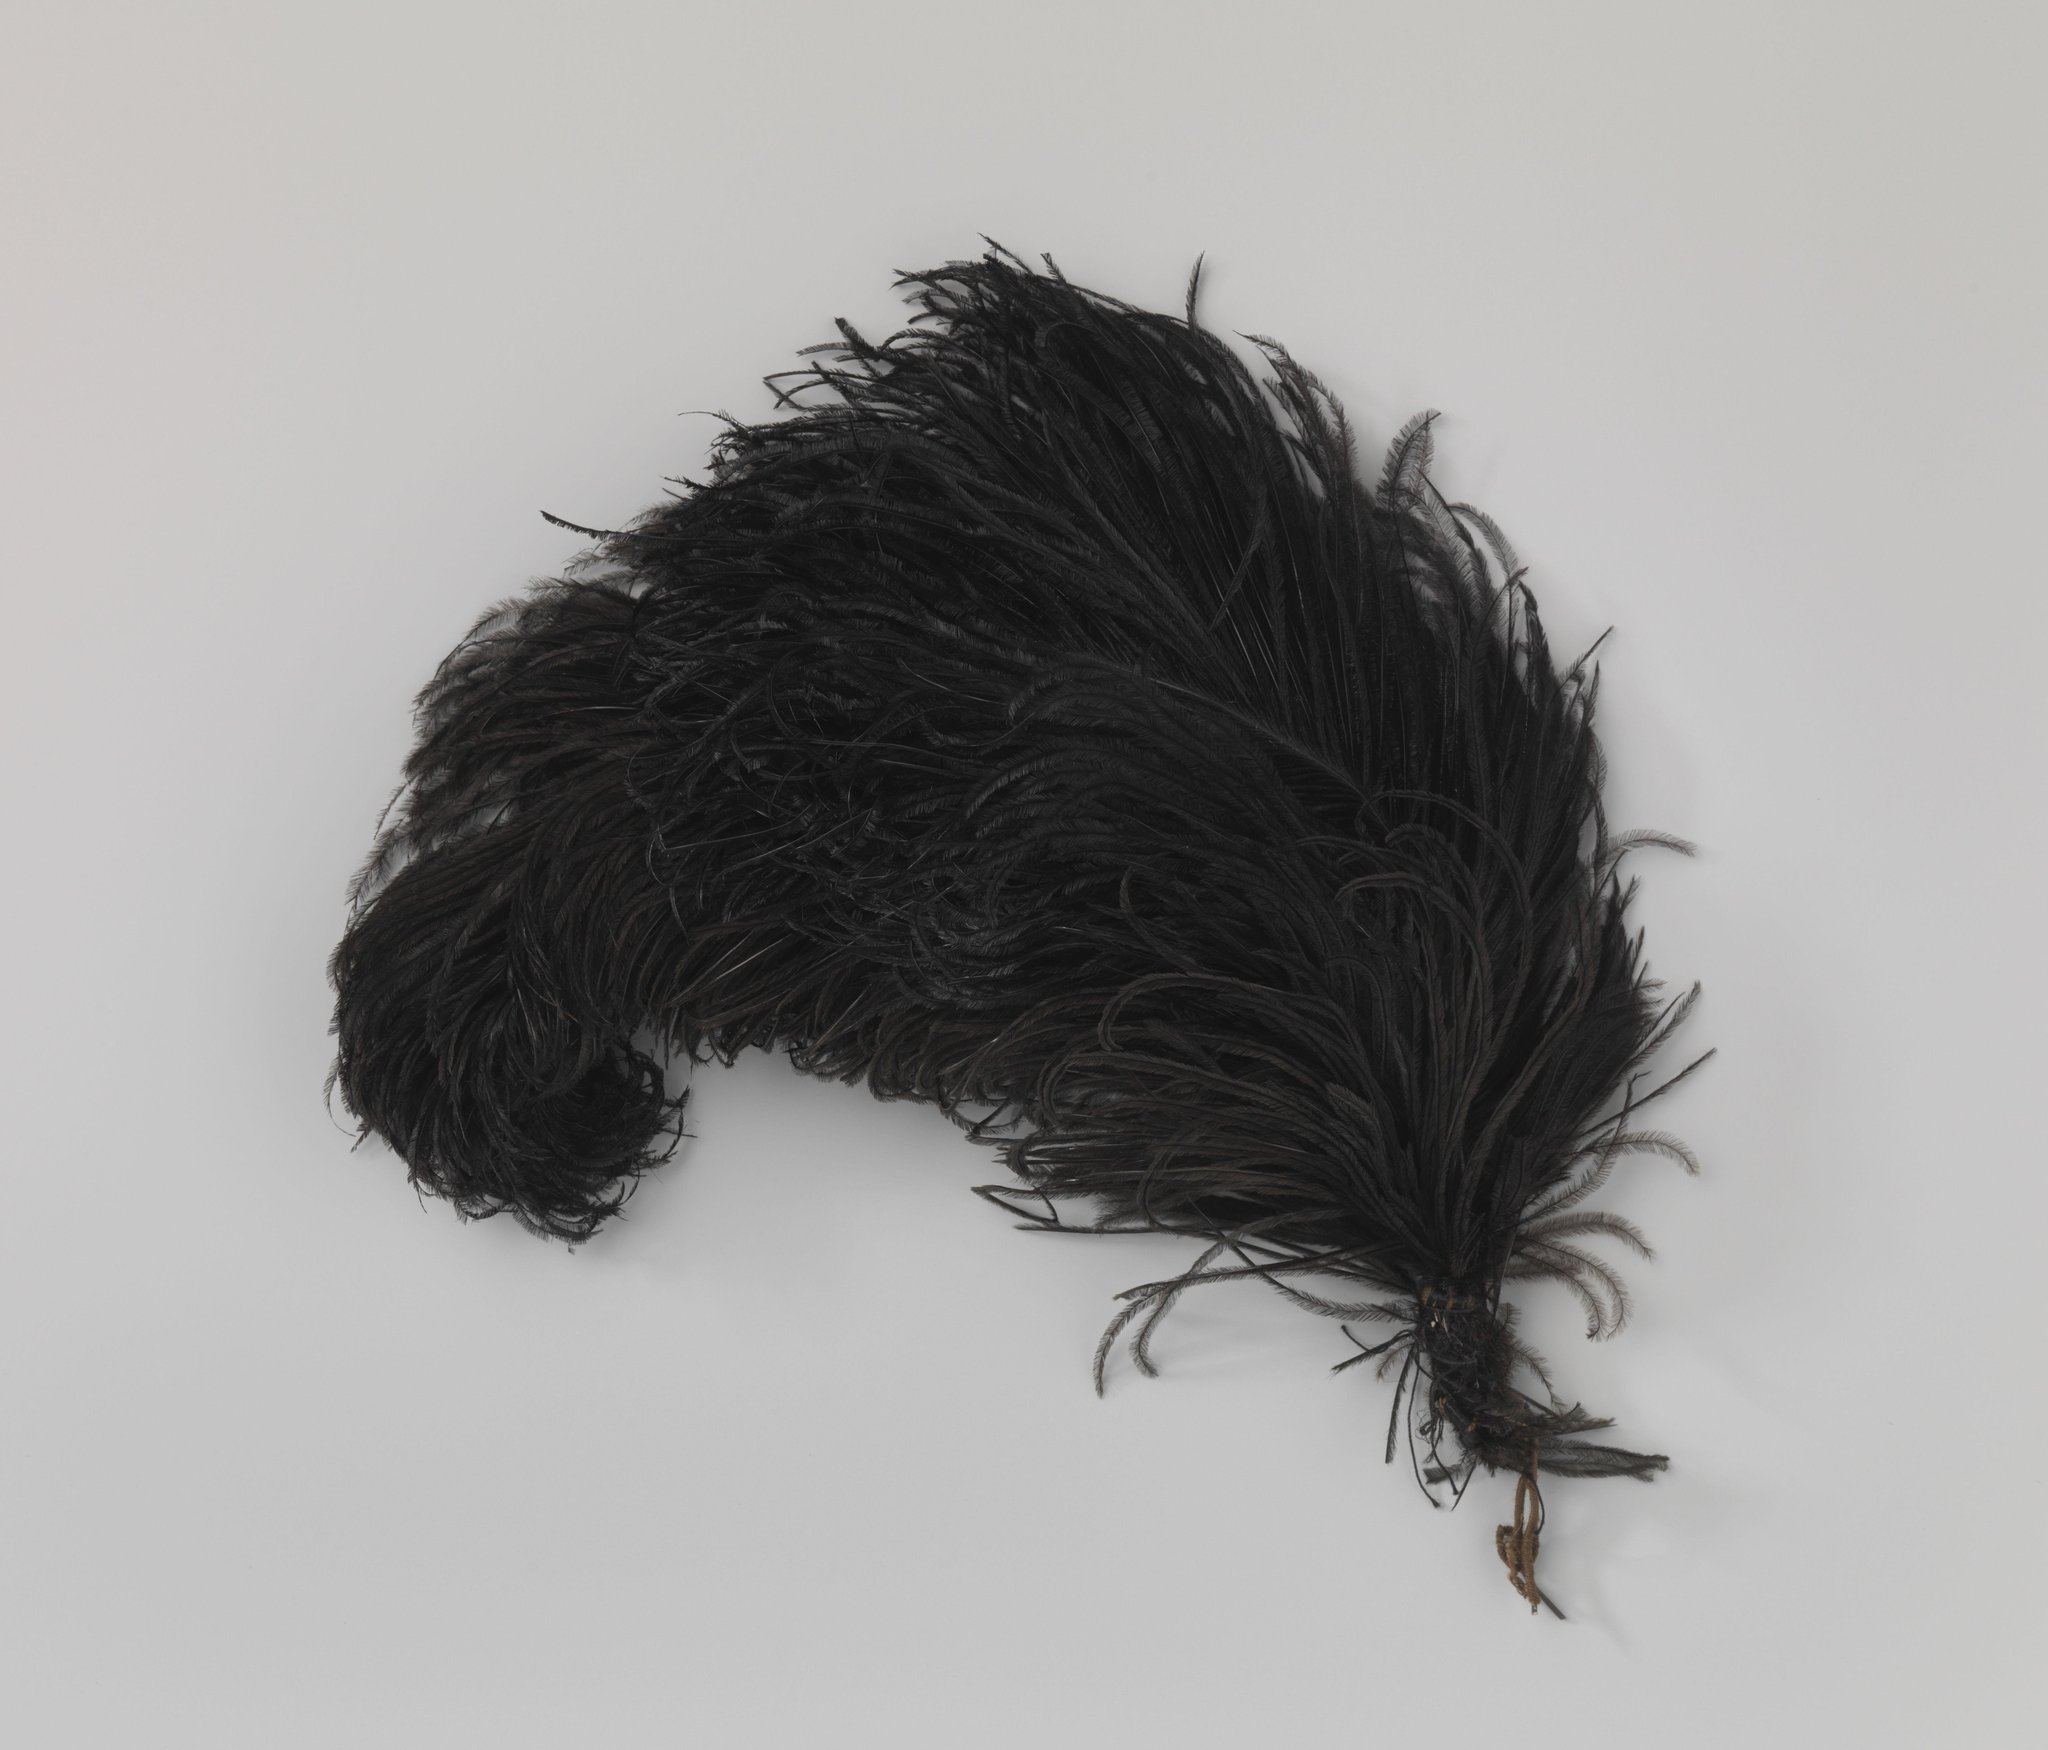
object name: hoedenveer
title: Toef van zwarte struisveren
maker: Anonymous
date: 1880-1940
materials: metal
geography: western europe